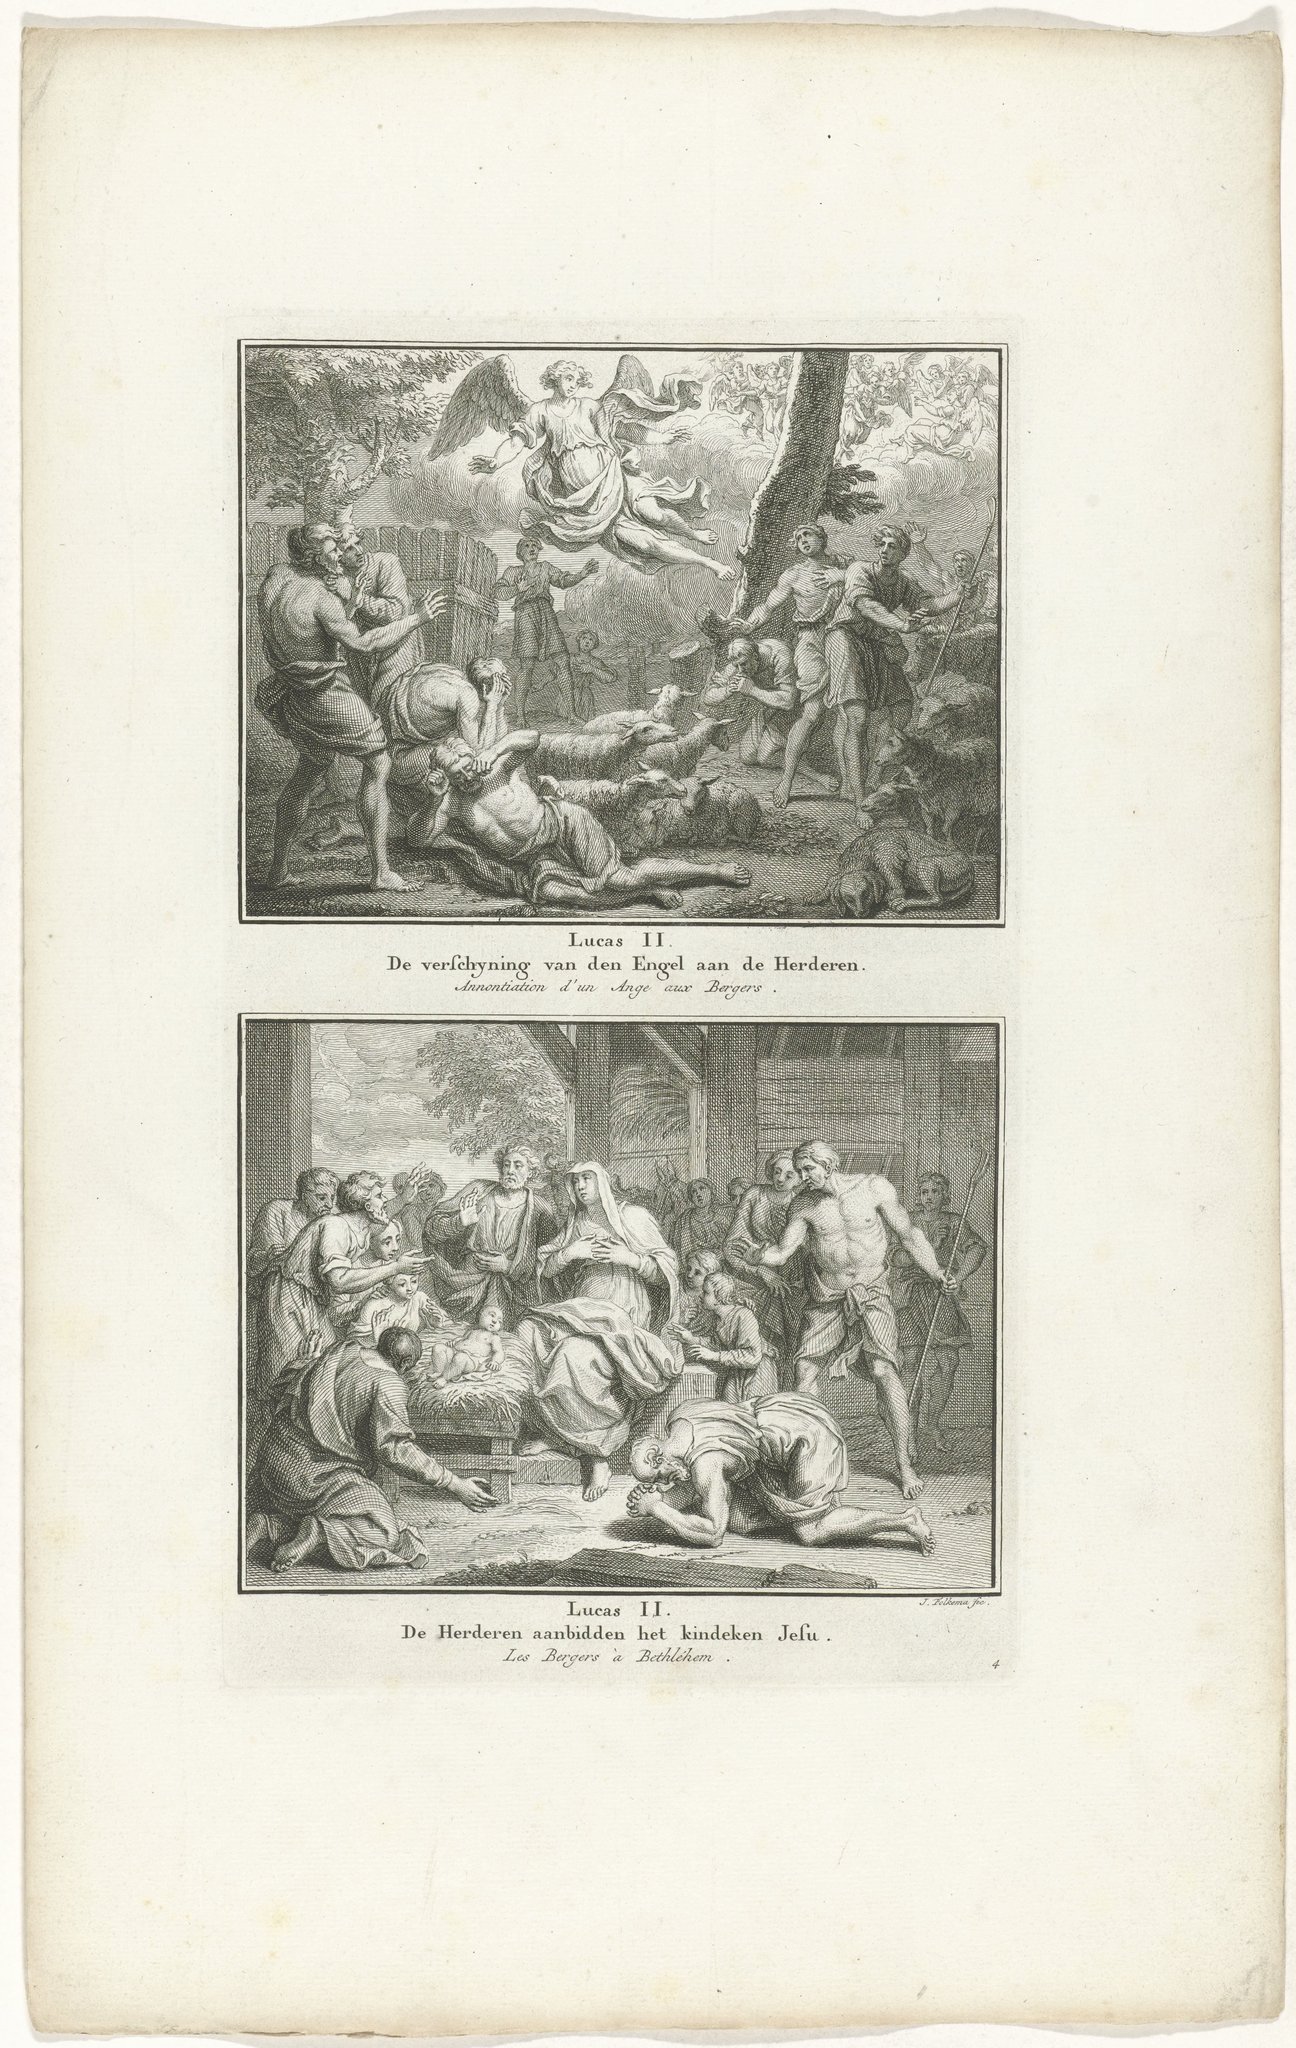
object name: print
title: Verkondiging aan de herders en de aanbidding door de herders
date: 1791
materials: paper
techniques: etching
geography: dordrecht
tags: adoration of the christ-child by the shepherds; mary and joseph present, annunciation of christ's birth to the shepherds (and/or shepherdesses) at night; a host of singing angels in the air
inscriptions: collector's mark, collector's mark: Lugt 2233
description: Illustratie uit: Hamelsveld, Ysbrand van. De gewigtigste geschiedenissen des Bybels, afgebeeld in twee honderd twee en vijftig printverbeeldingen (...) met eene zaaklijke uitbreiding opgehelderd. Amsterdam / Dordrecht: Jan de Groot / Abraham en Pieter Blussé.